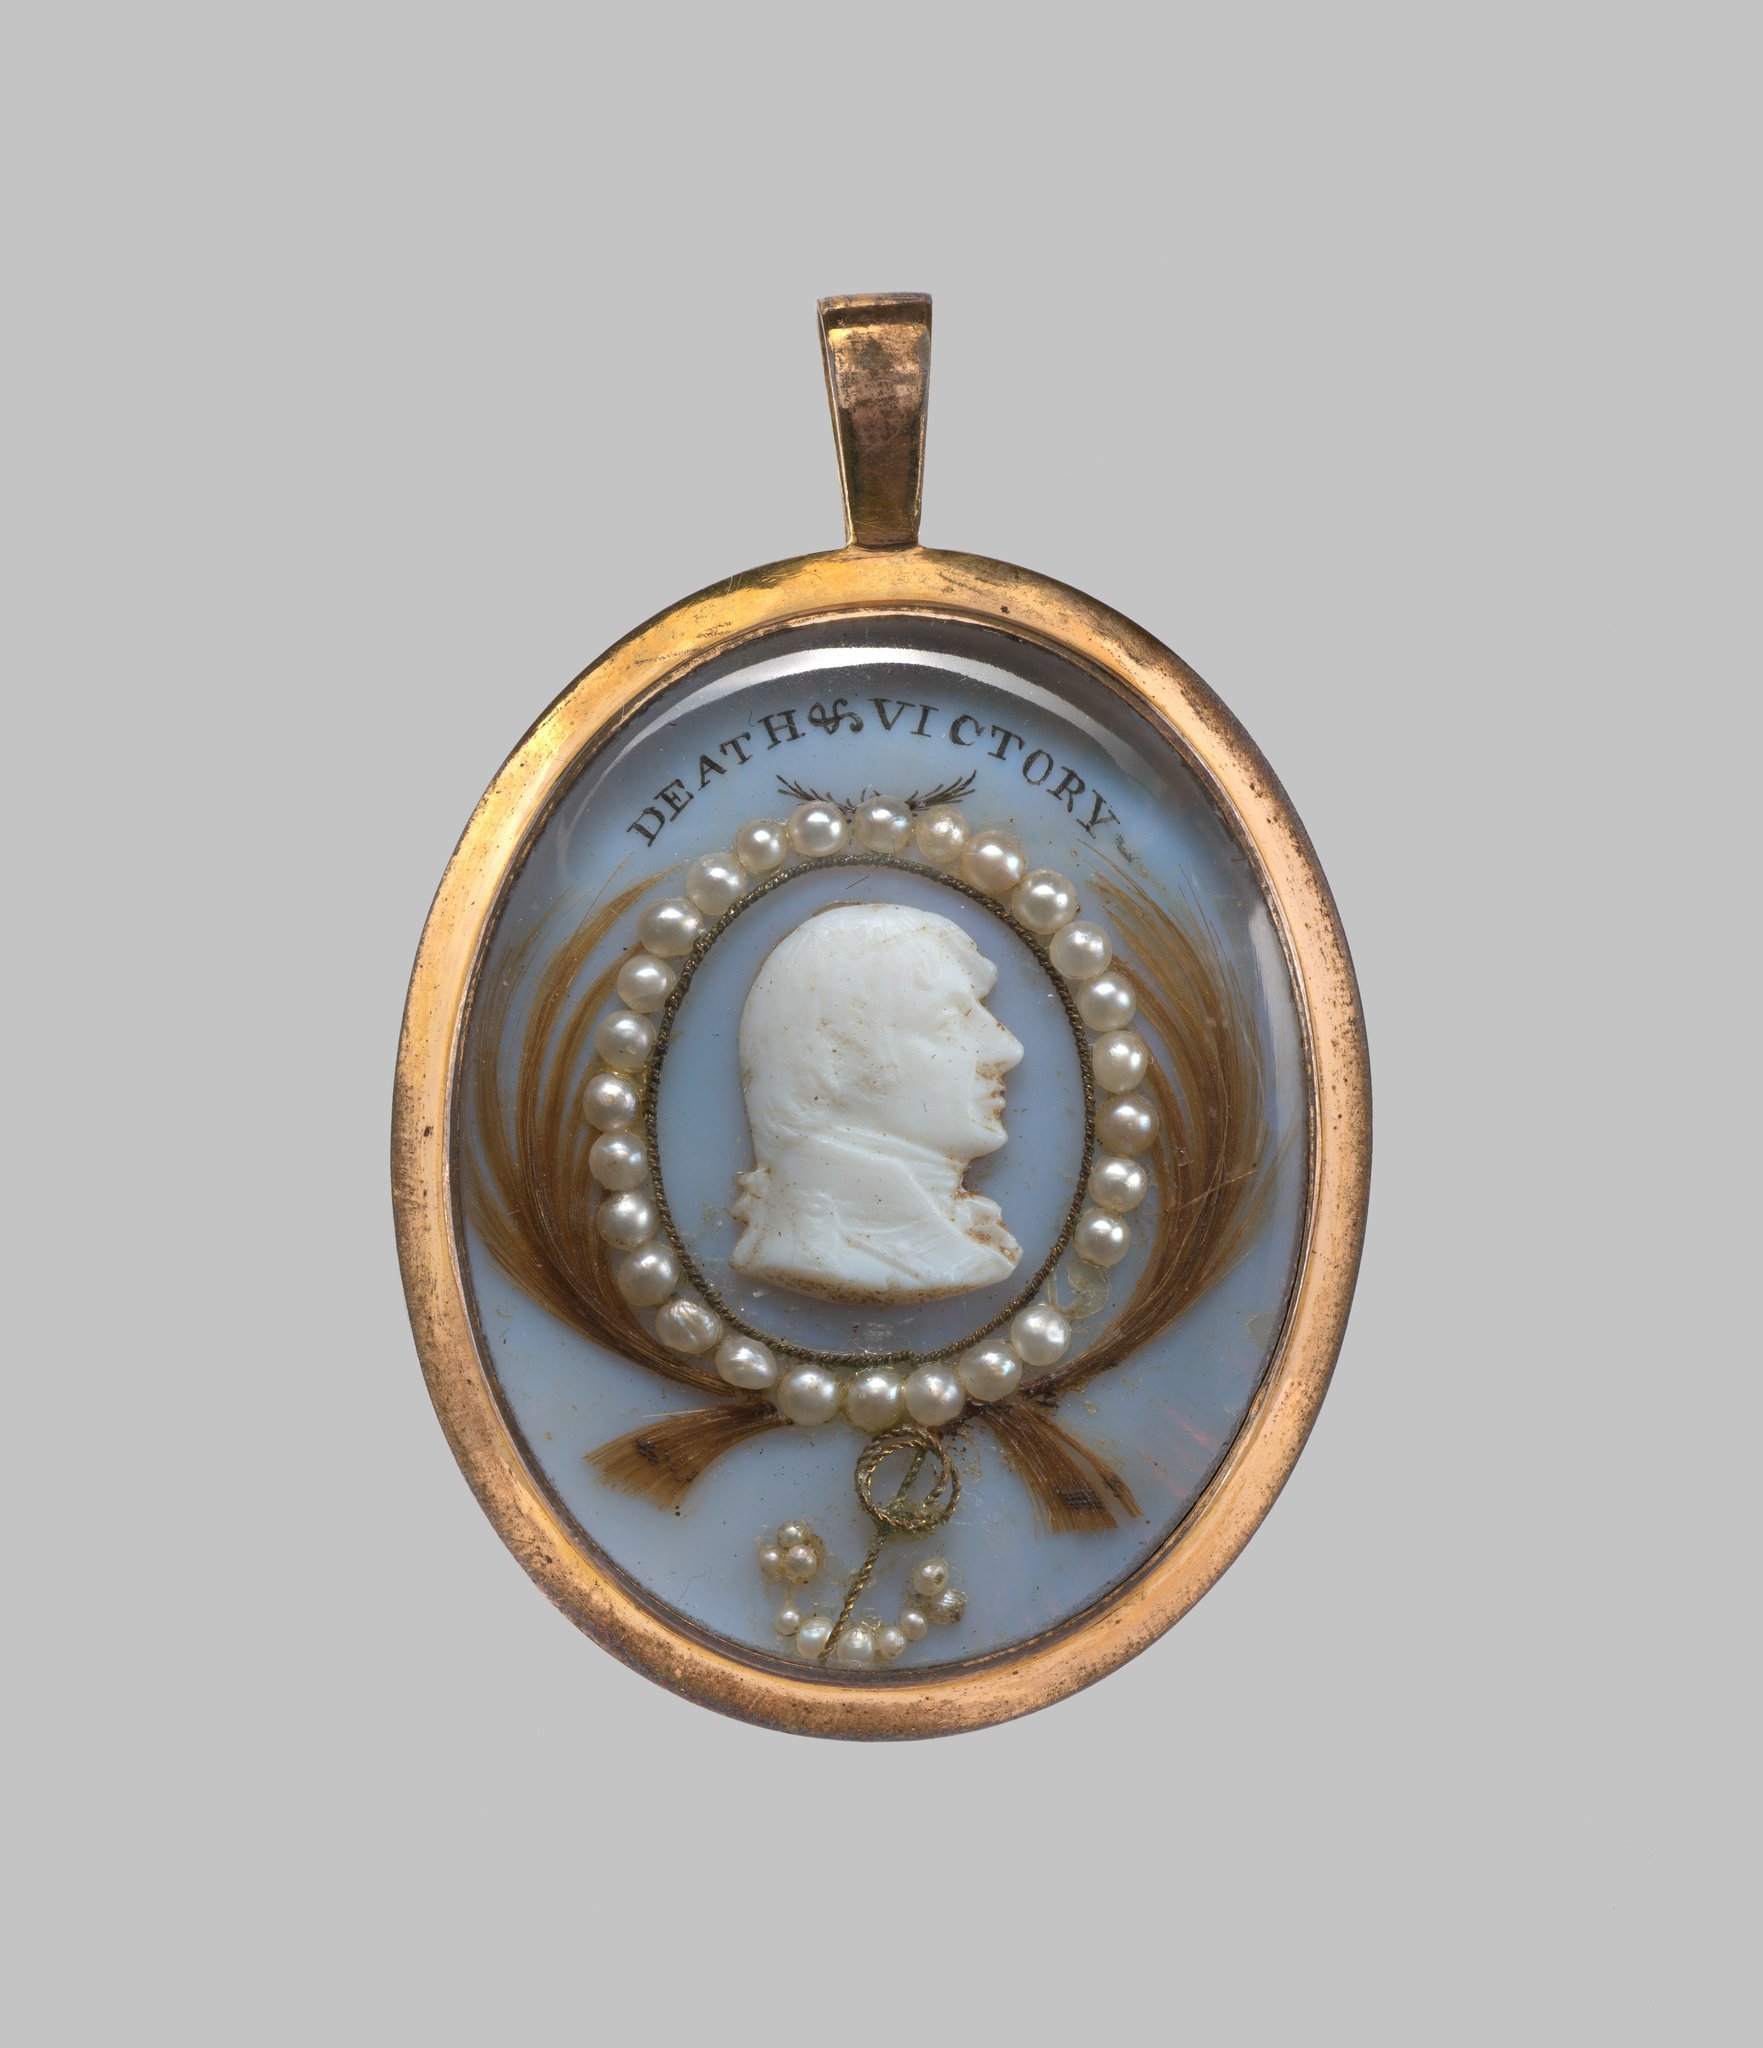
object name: locket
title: Viscount Admiral Lord Nelson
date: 1805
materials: gilt copper, glass, gold, hair, paste, pearl, silk, metal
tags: men,admirals